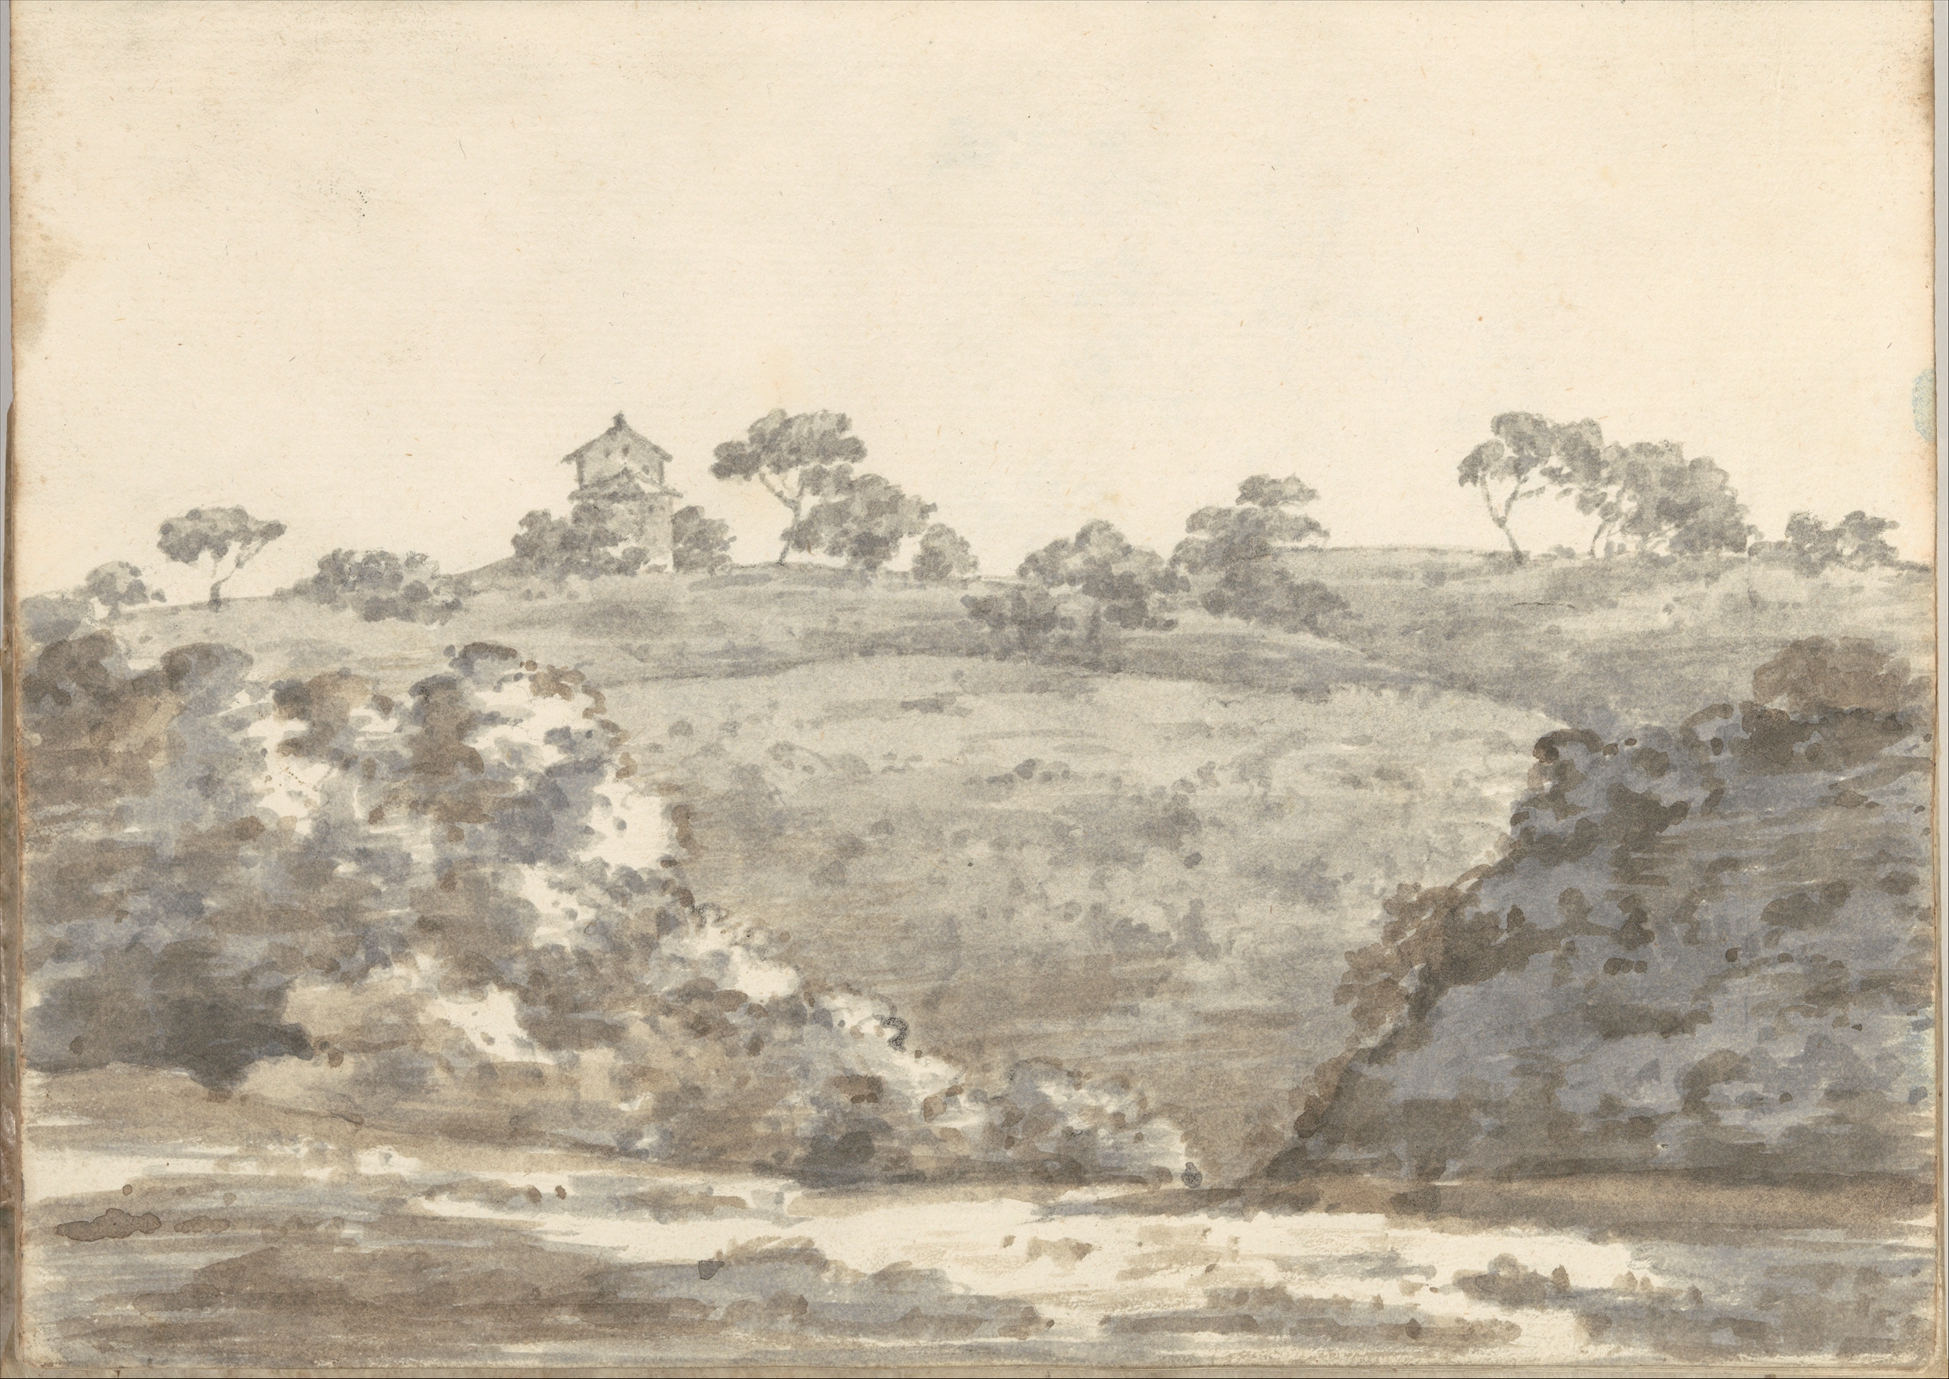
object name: drawing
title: Landscape with a two-story building on a hill (Smaller Italian sketchbook, leaf 29 recto)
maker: joseph wright (wright of derby)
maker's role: artist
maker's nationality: british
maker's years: 1734-1797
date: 1774-1775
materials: graphite, ink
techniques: wash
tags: buildings,hills,landscapes